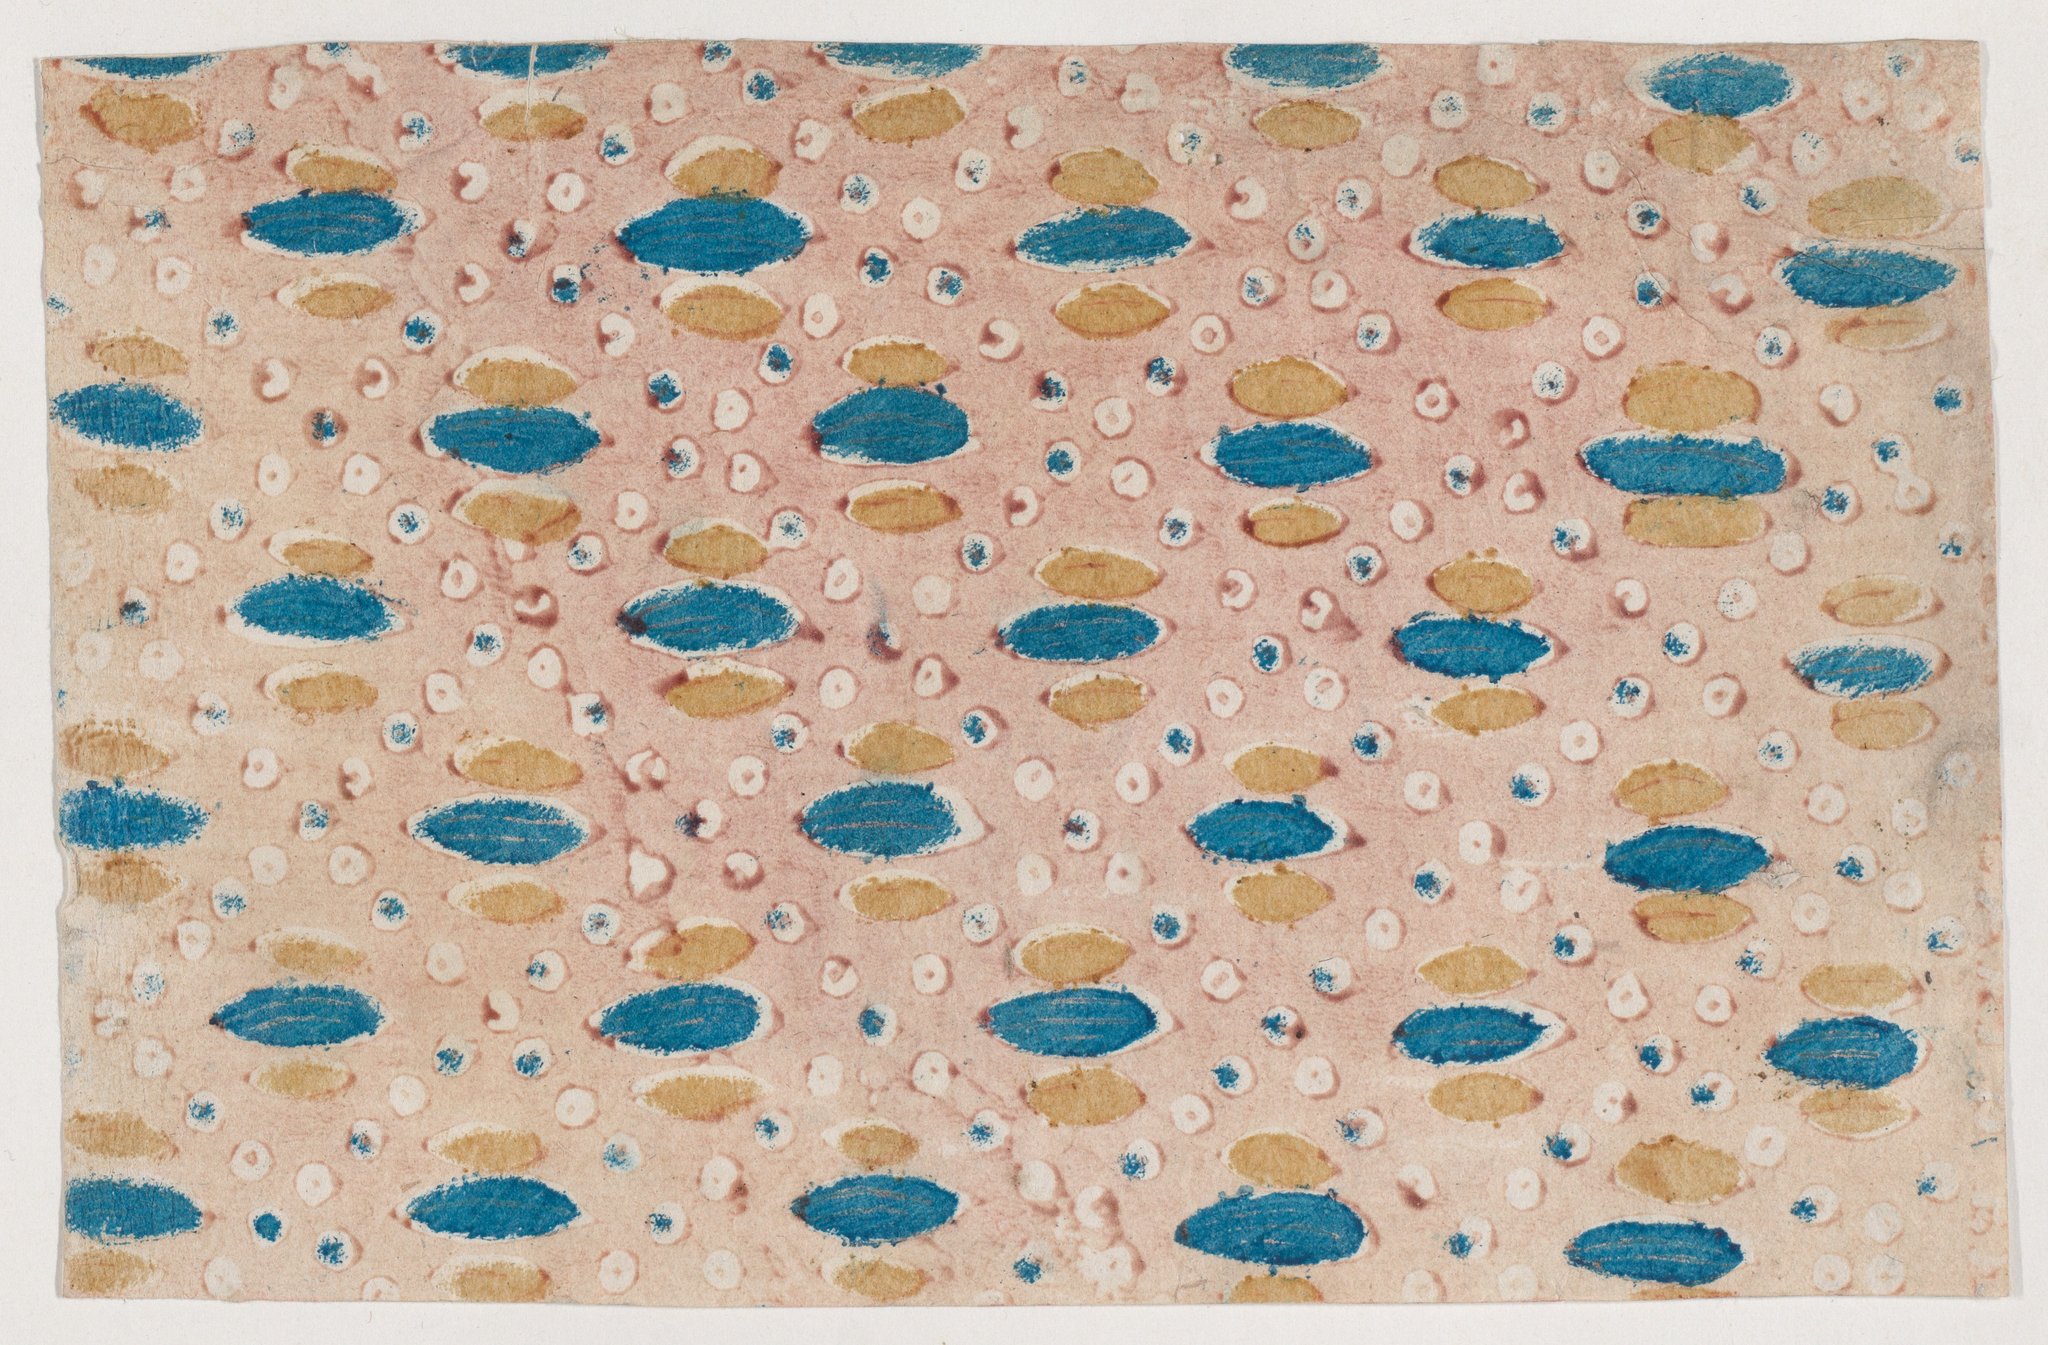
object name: print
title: Sheet with overall pattern of circles and ovals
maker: Anonymous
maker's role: artist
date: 1801-1900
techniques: relief print